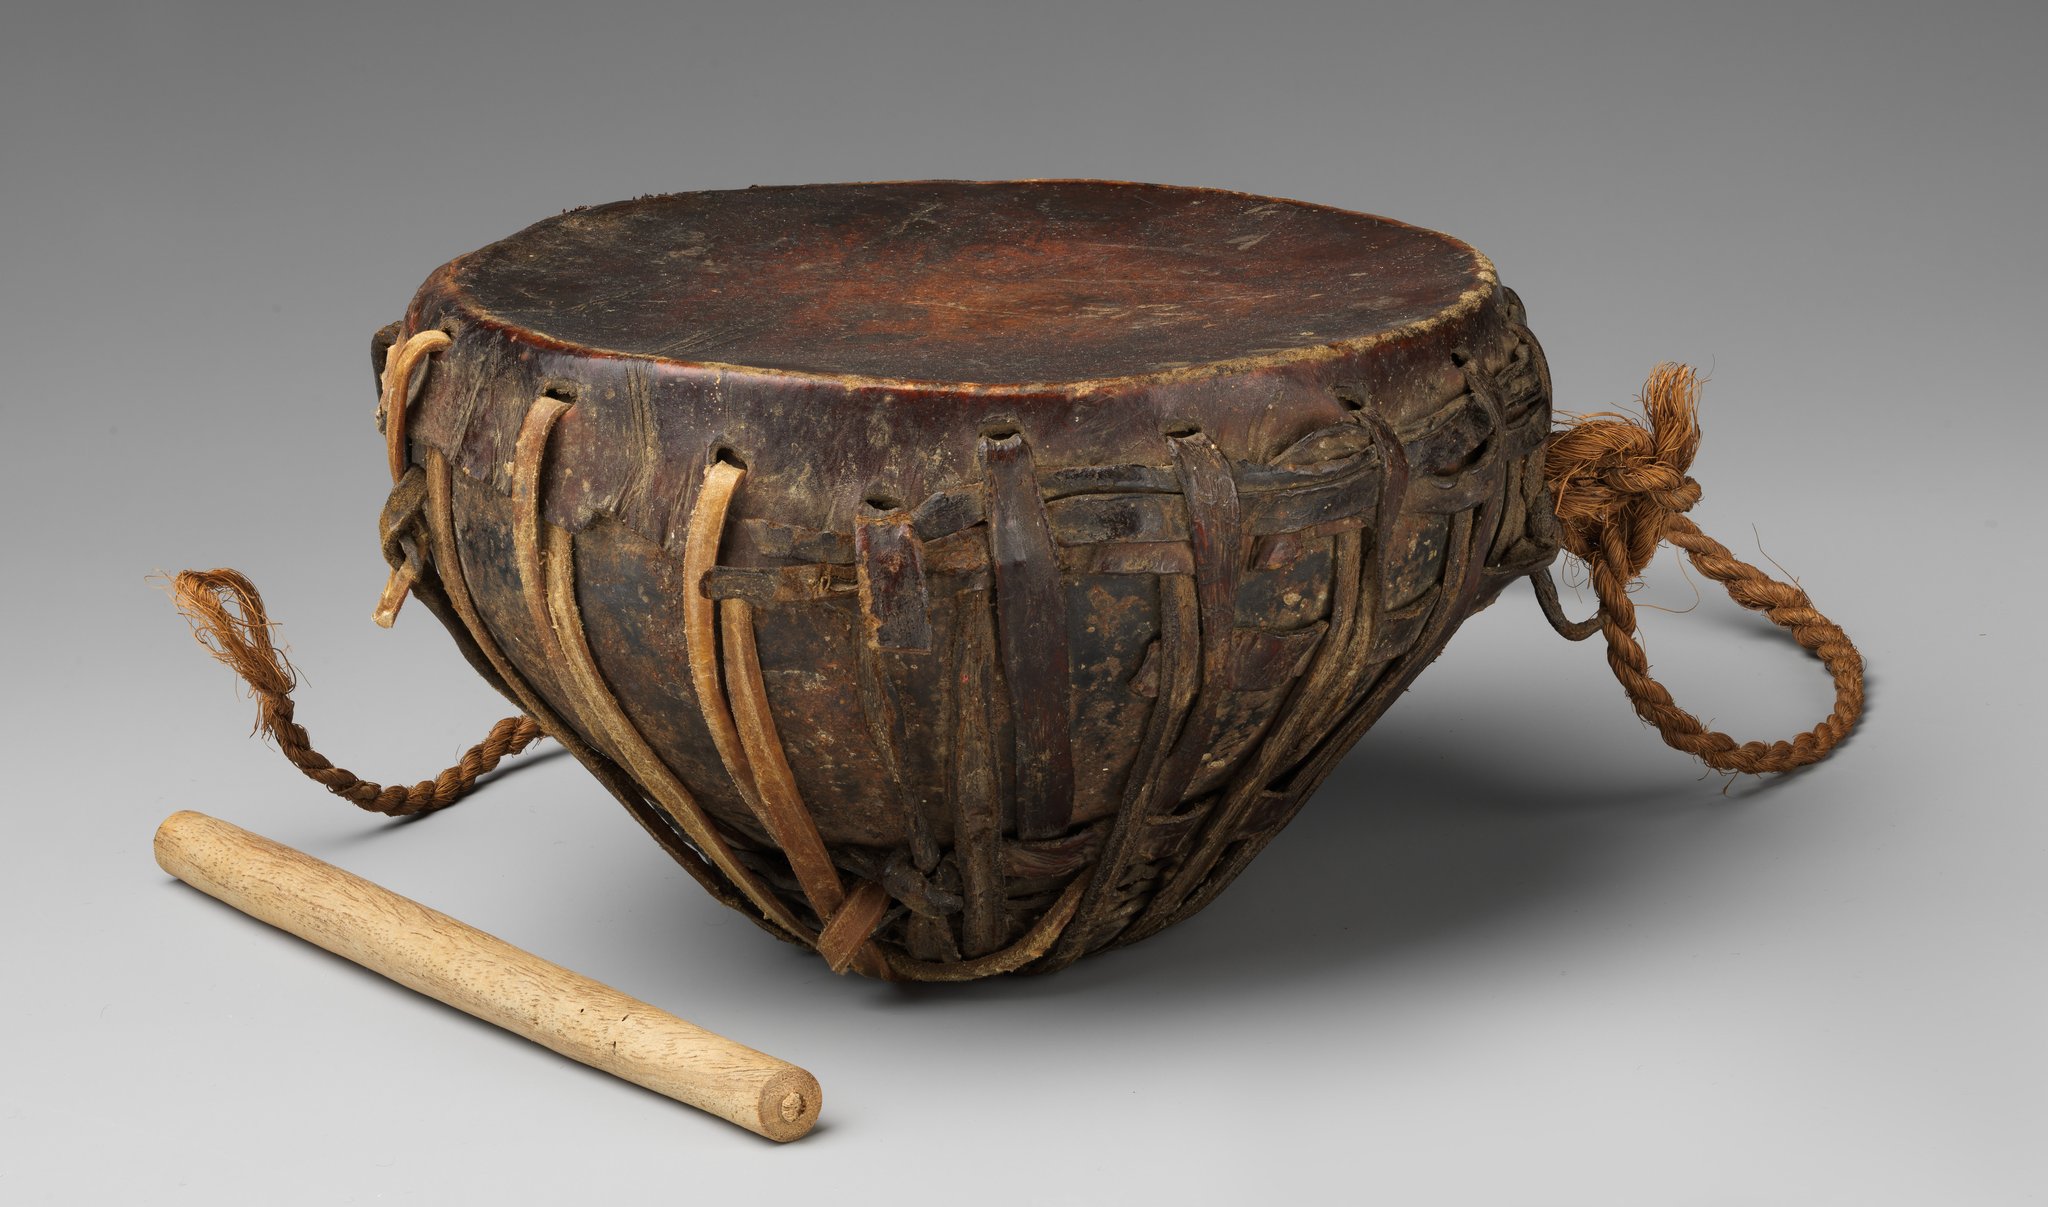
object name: tyamko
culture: nepalese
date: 1801-1900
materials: brass, wood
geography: nepal